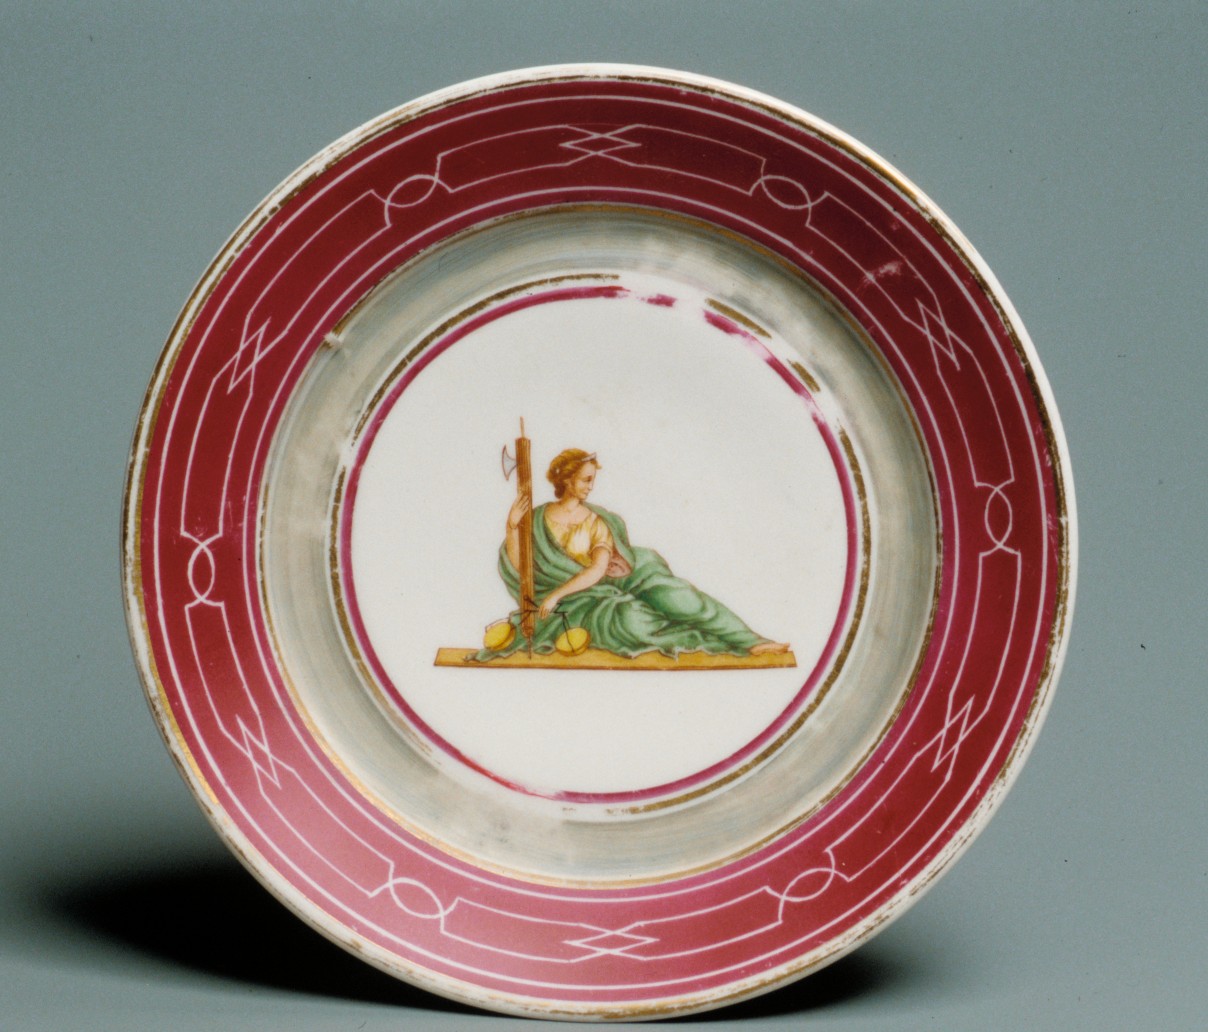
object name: compote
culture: american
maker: union porcelain works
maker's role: maker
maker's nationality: american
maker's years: 1863-1922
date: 1875-1890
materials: porcelain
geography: united states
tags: women